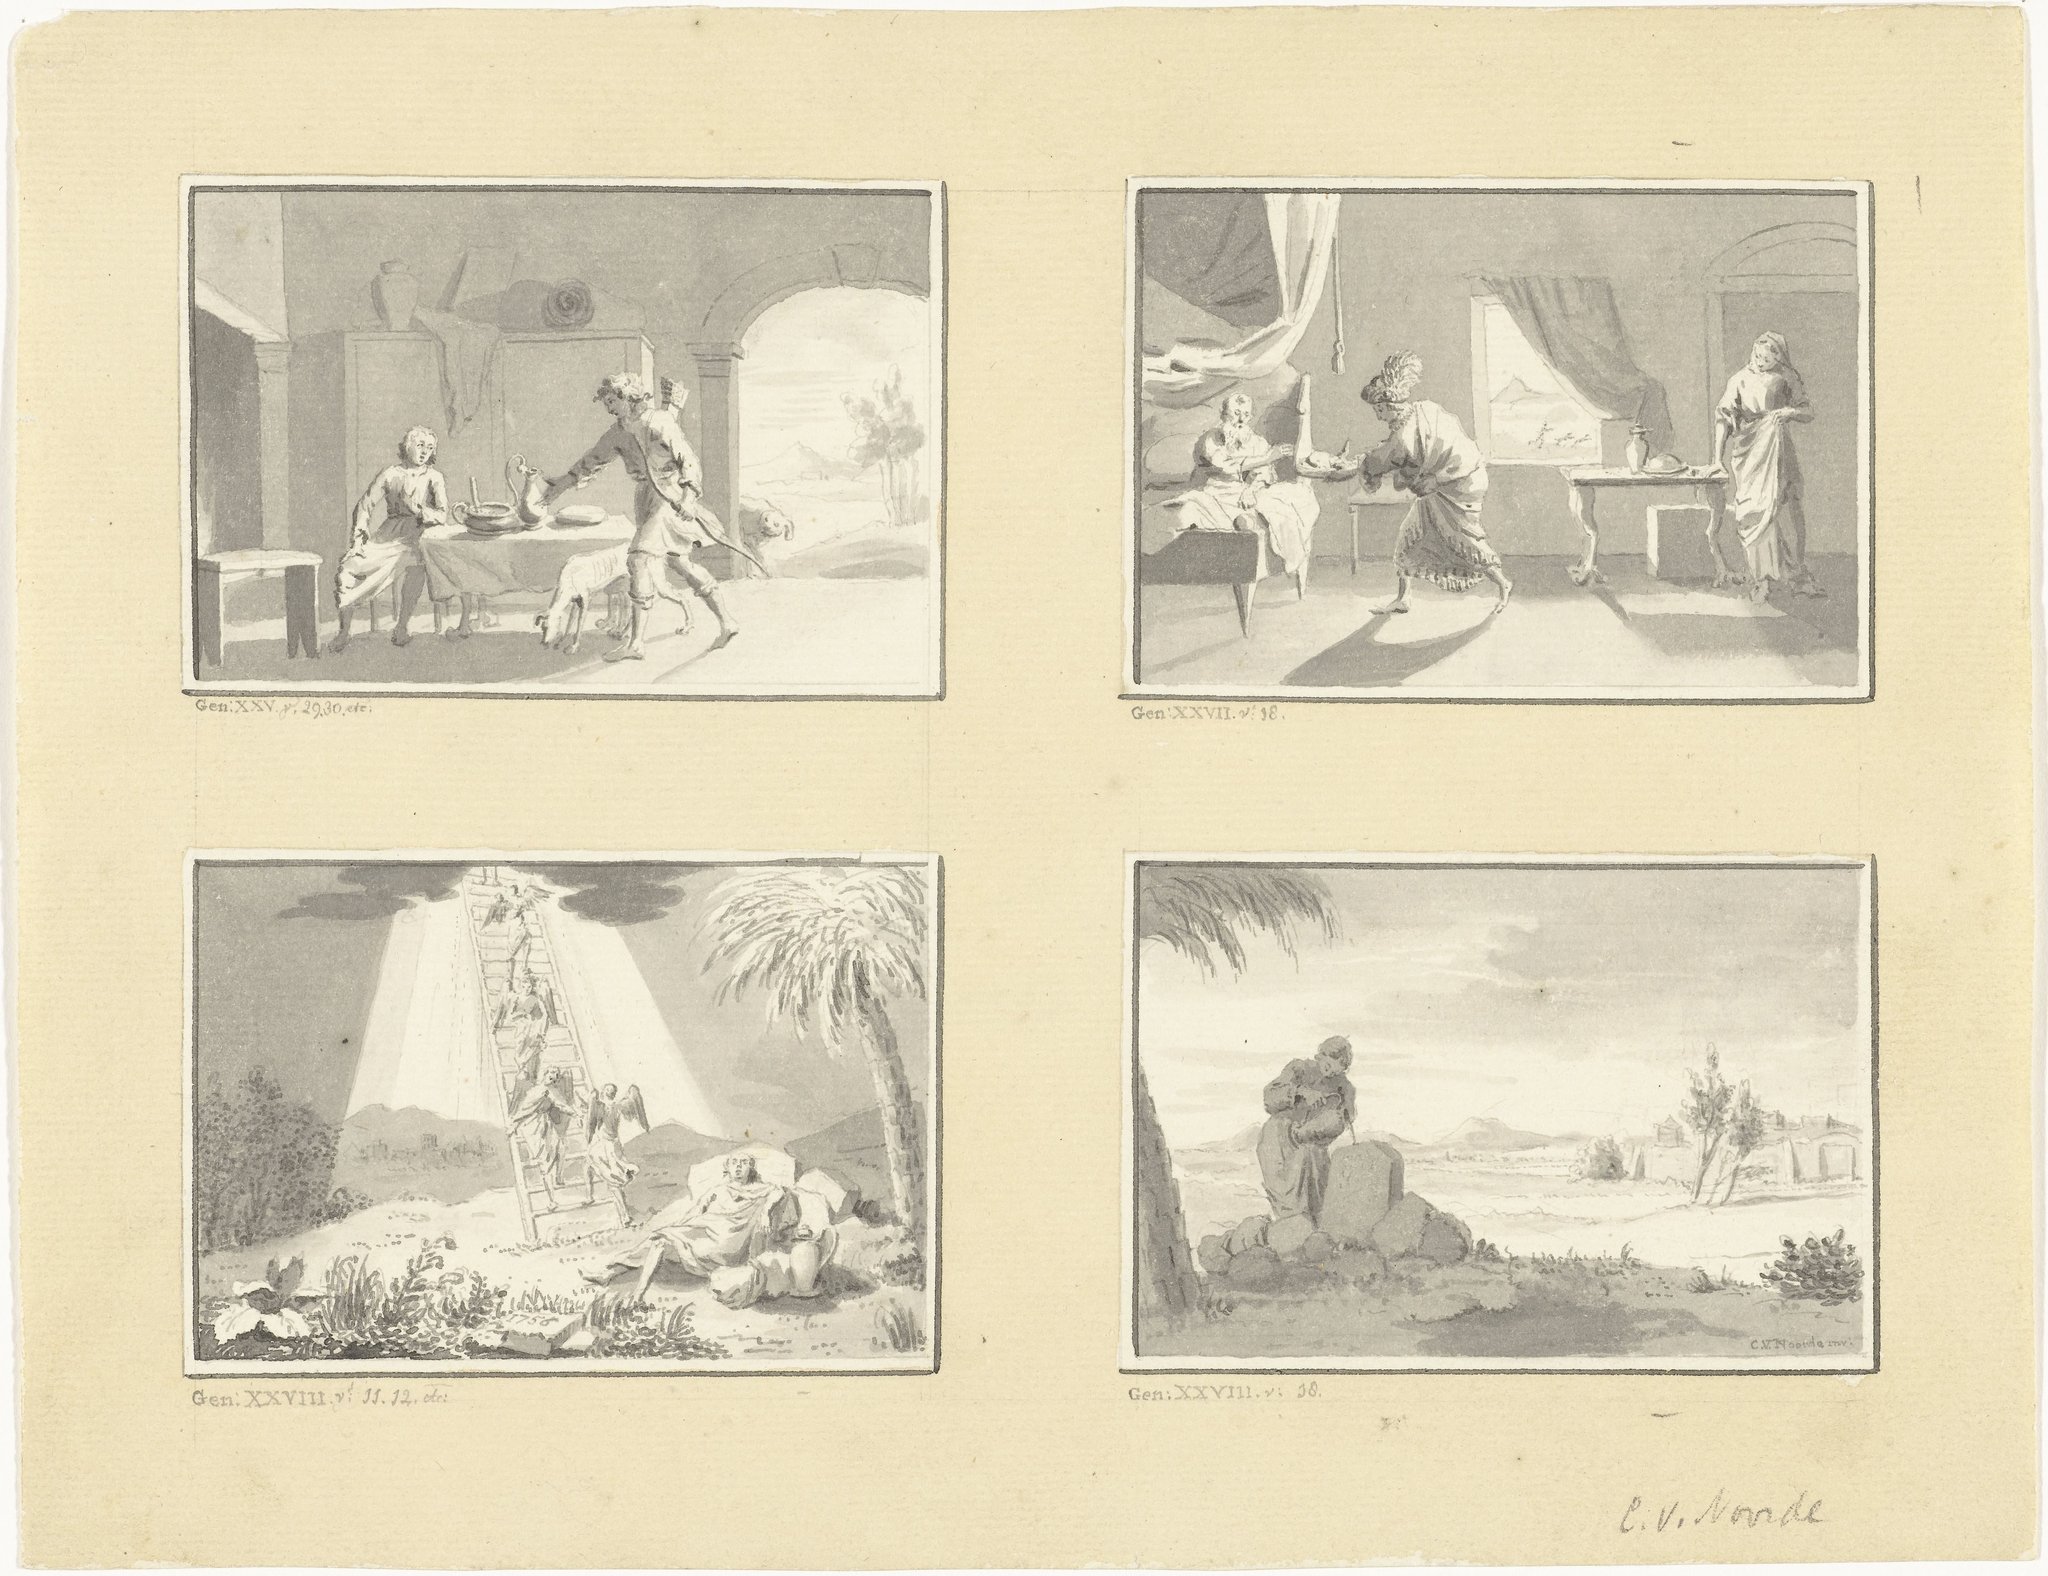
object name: drawing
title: Vier illustraties uit het verhaal van Izaäk, Jakob en Ezau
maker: cornelis van noorde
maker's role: draughtsman, print maker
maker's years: 1731-1795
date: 1741-1795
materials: ink, paper, pencil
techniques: brush, pen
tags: rebekah preparing the meal for isaac, isaac lying in bed blesses jacob who, disguised in esau's clothes, brings food to his father; jacob's hands and neck are covered with goatskins, jacob awakes, anoints the stone and names the place bethel, the dream of jacob: while sleeping on the ground with a stone for pillow jacob sees a ladder reaching from earth to heaven with angels going up and down; usually with god at the top of the ladder, esau, returning hungry from the hunt, sells his first birthright to jacob for a pottage of lentils